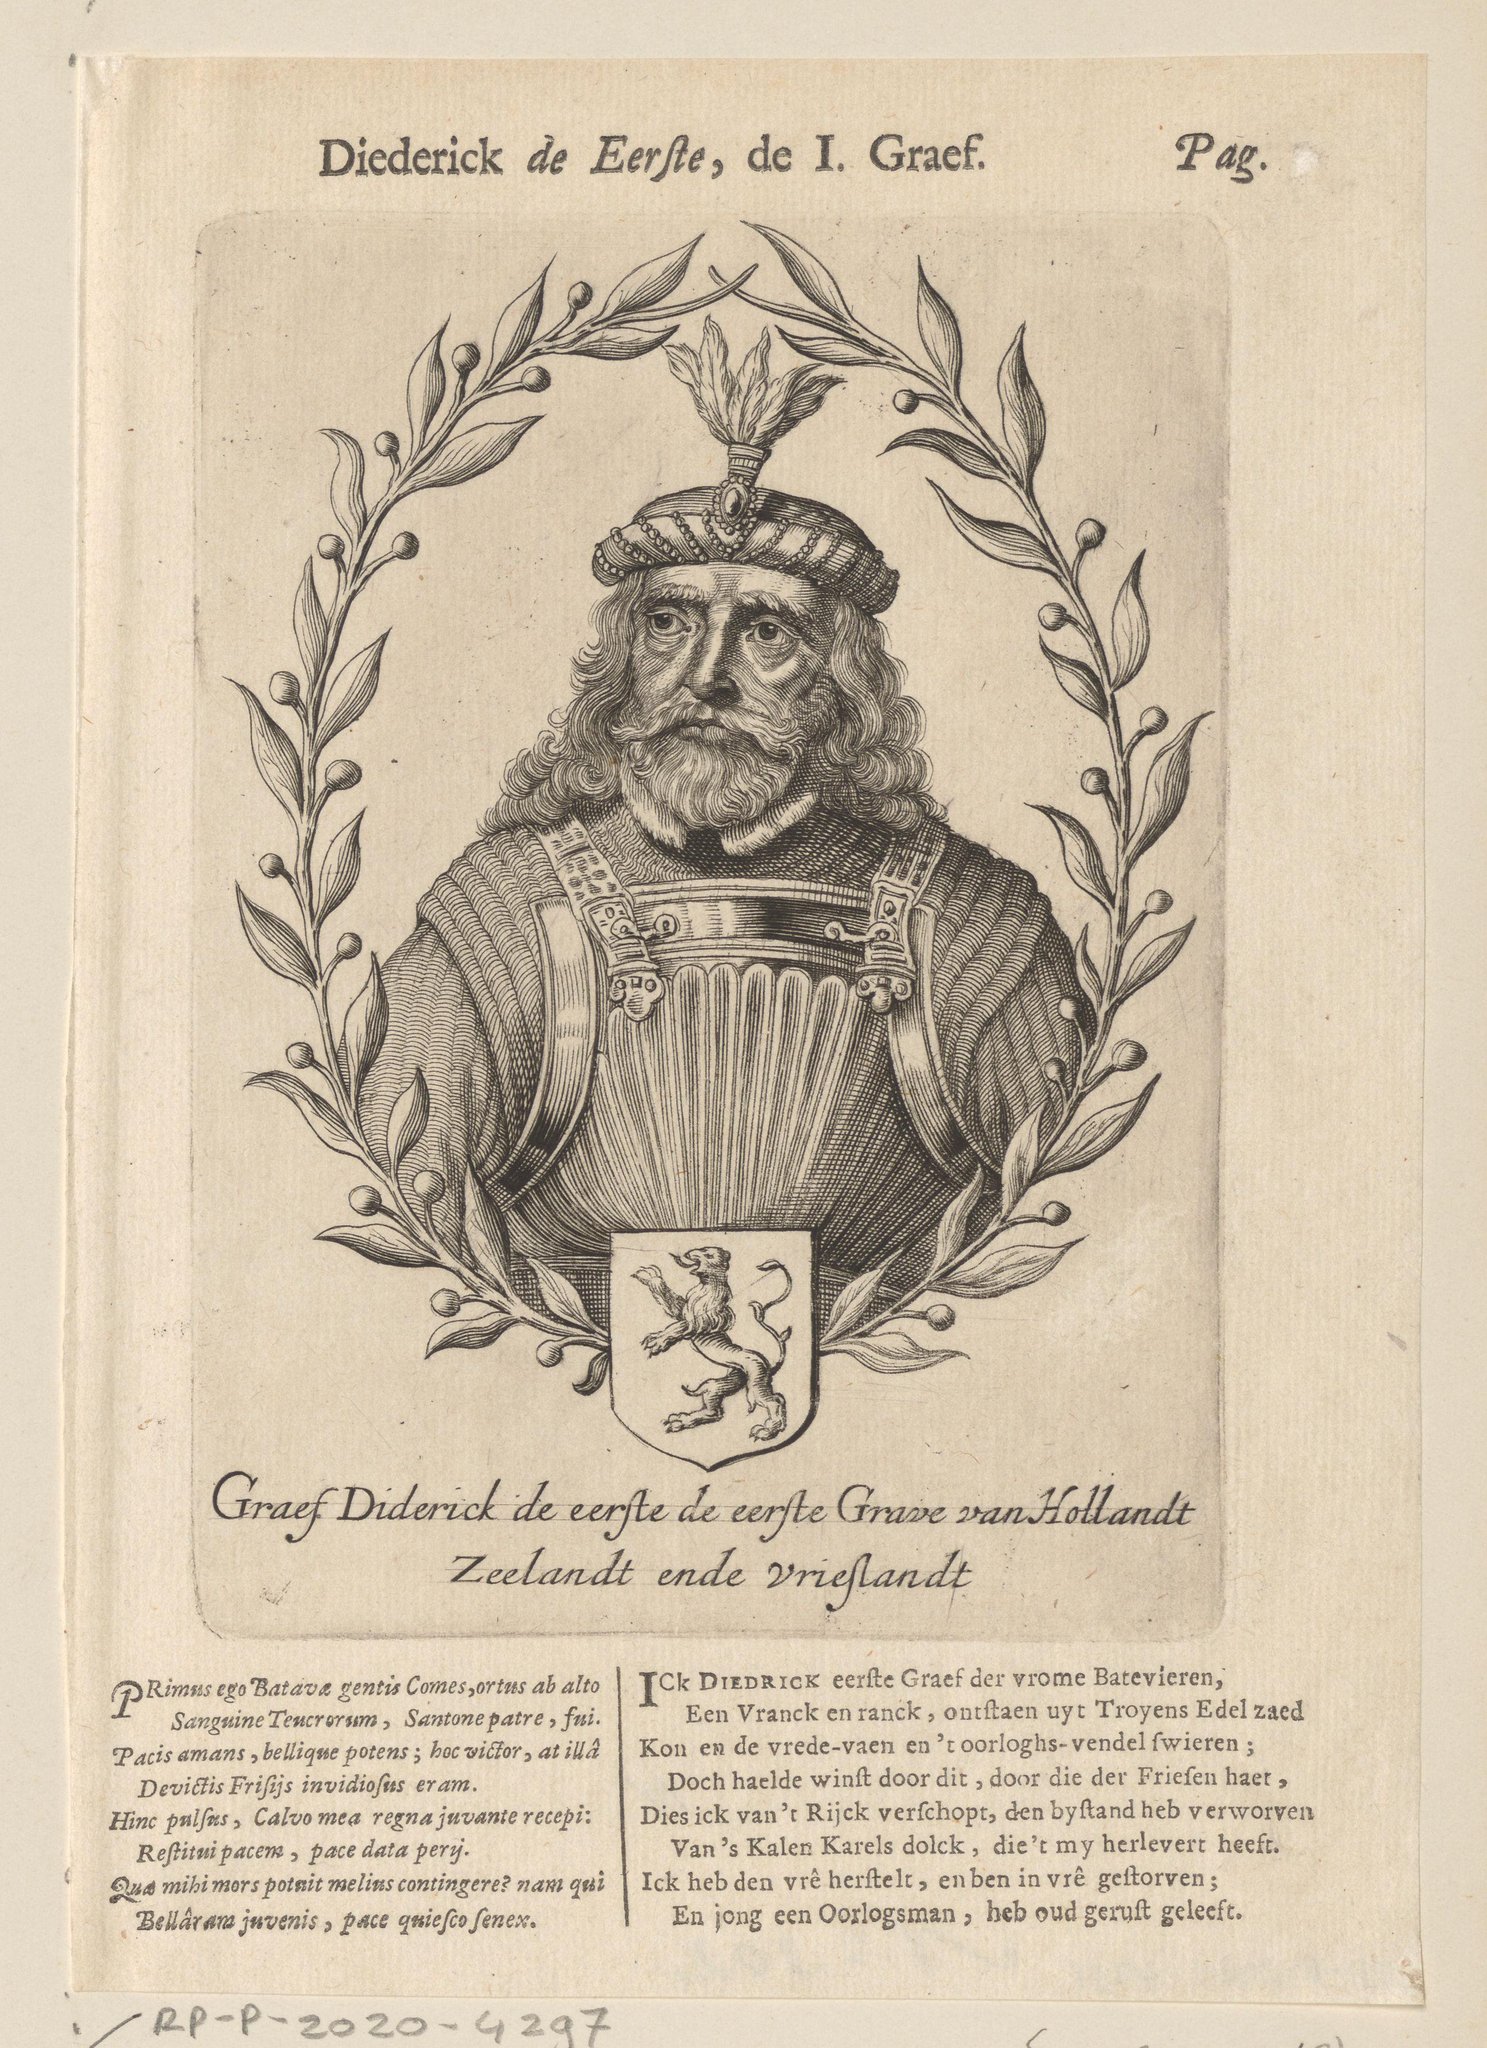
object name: book illustration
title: Portret van Dirk I, graaf van Holland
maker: Anonymous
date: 1677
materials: paper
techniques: engraving, letterpress printing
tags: historical persons, head-gear: hat, ruler, sovereign, nobility and patriciate; chivalry, knighthood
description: Prent met tekst op verso gebruikt in: Scriverius, Petrus. Hollandsche, Zeelandsche ende Vriesche chronyck. Den Haag: Jasper Doll en Johan Veely, 1677, p. 1.